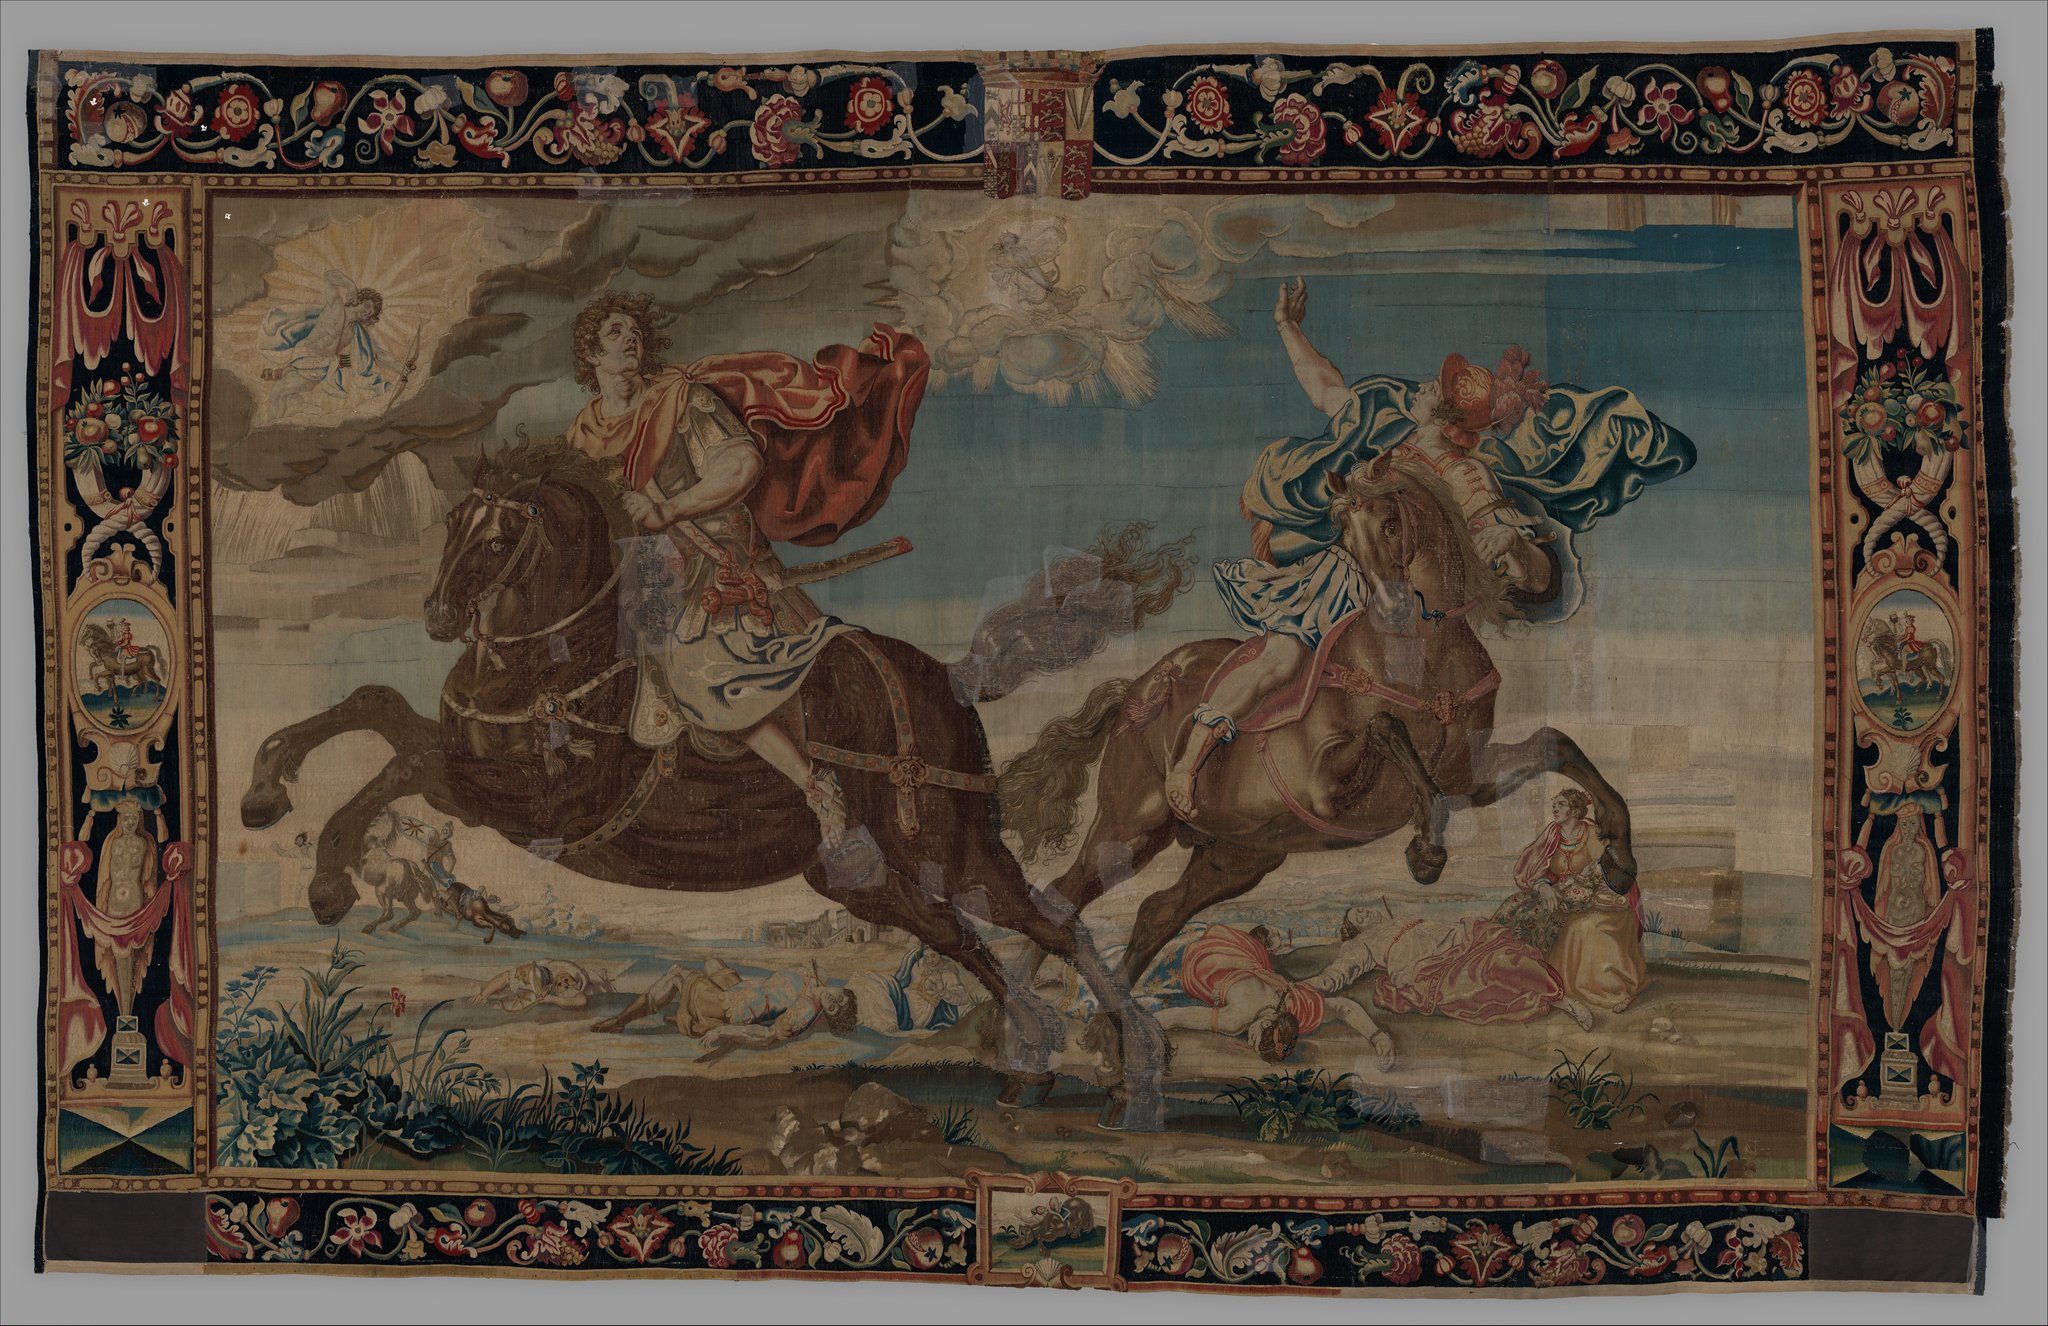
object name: tapestry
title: The Destruction of the Children of Niobe from a set of "The Horses"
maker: frans cleyn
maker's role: designer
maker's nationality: german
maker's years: 1582-1658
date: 1650-1670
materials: silk, wool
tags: men,women,apollo,diana,horses